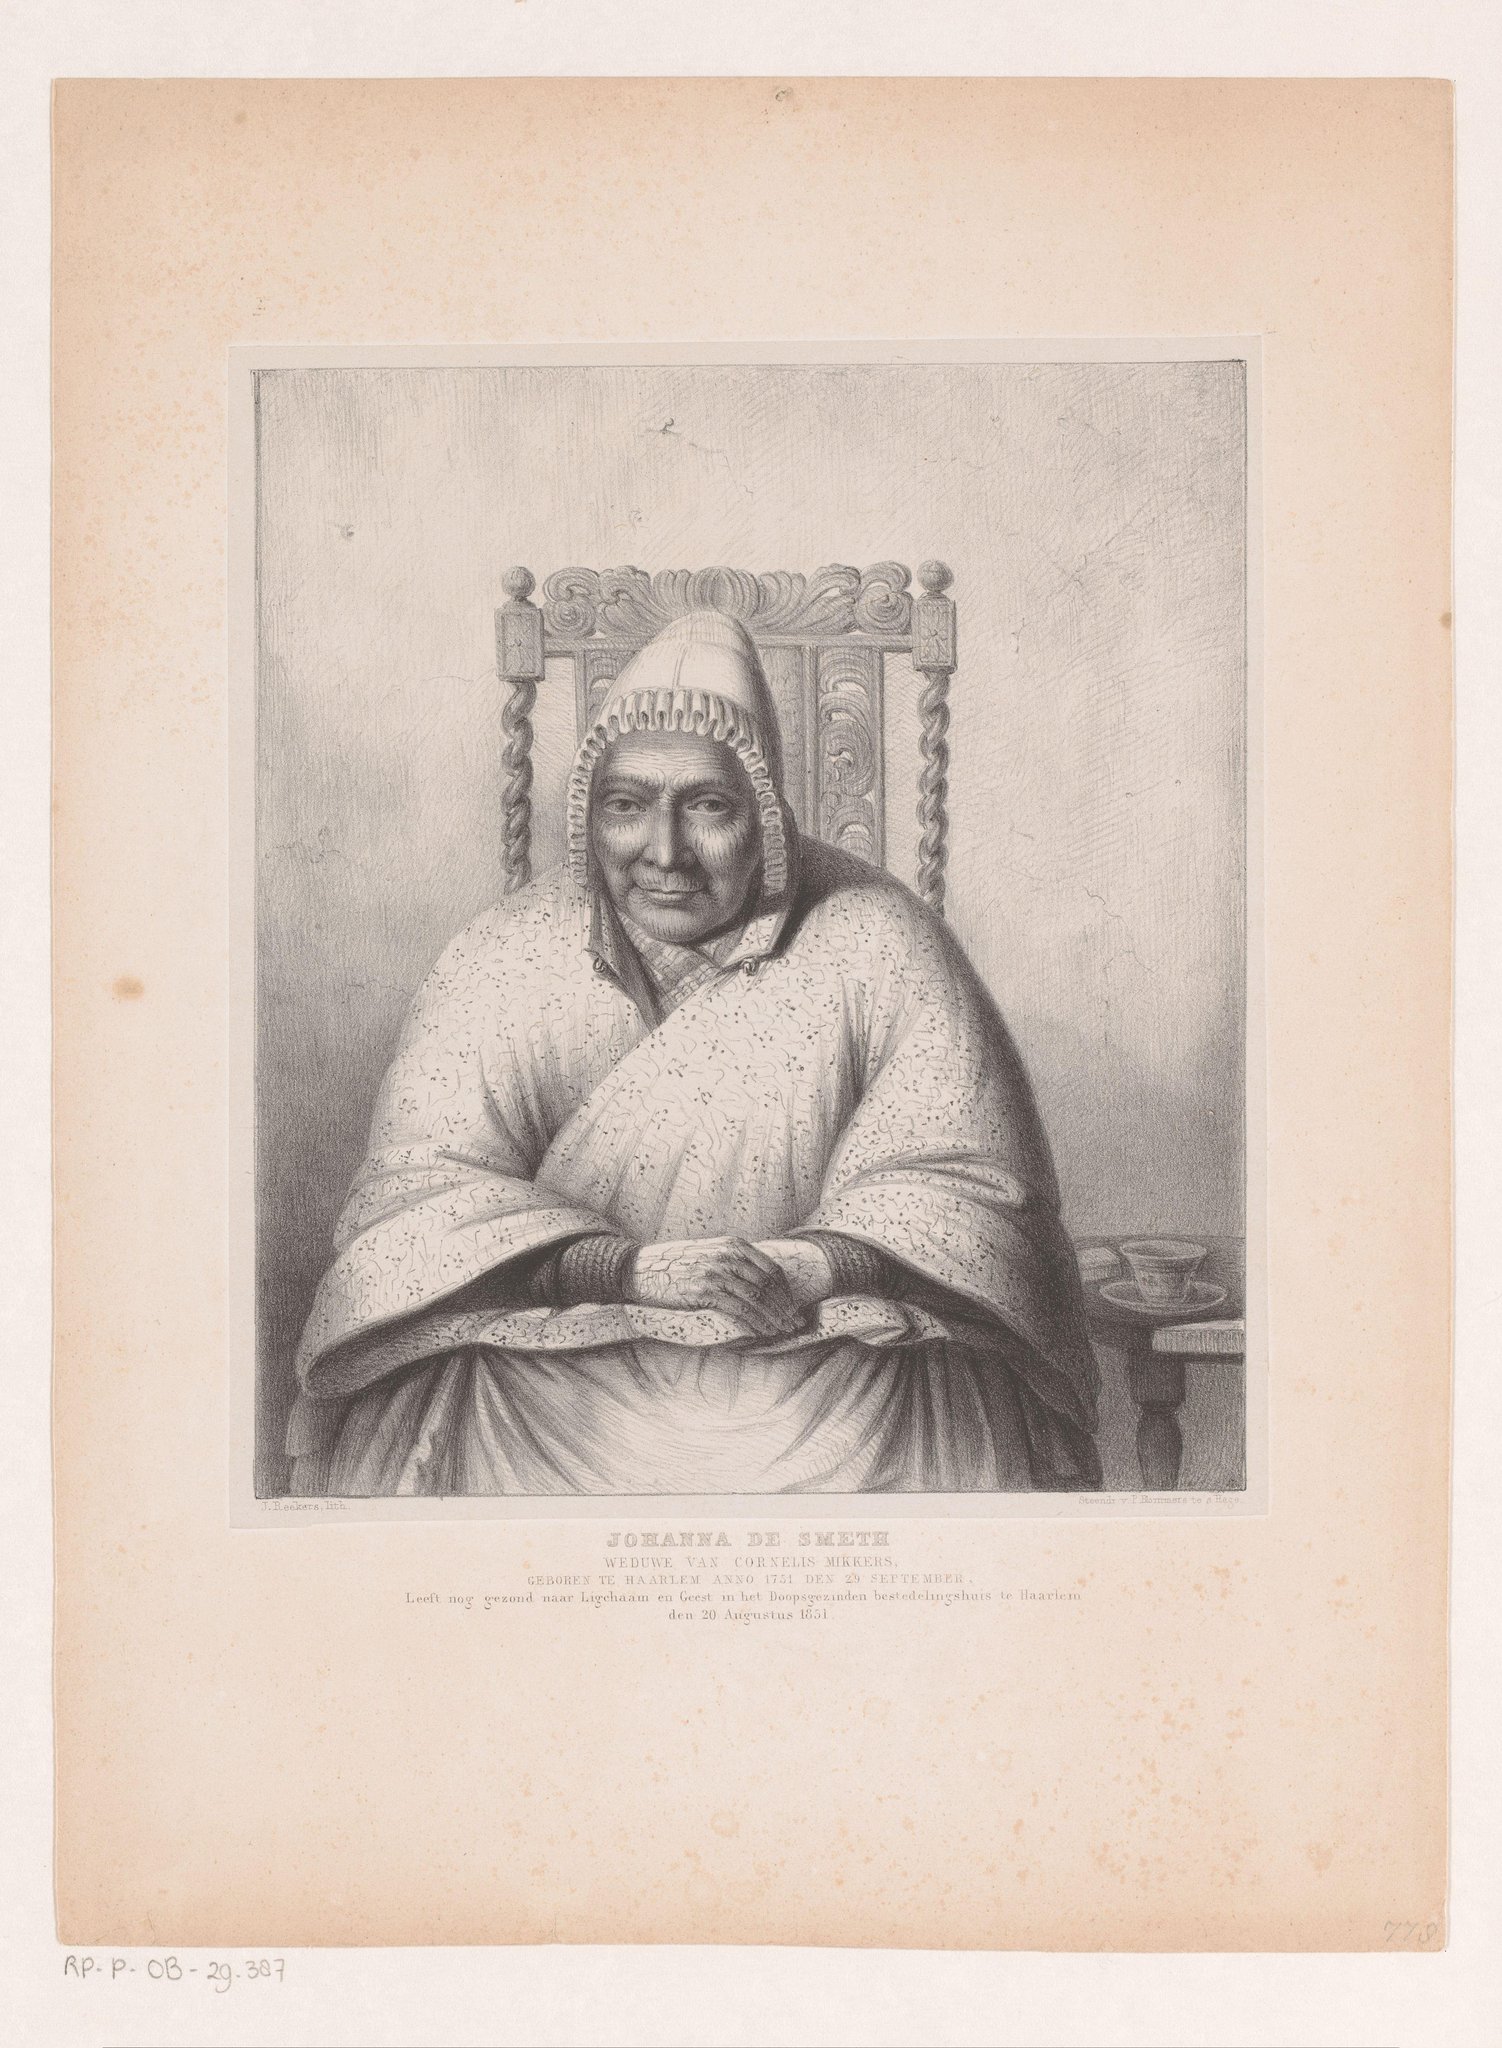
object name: print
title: Johanna de Smeth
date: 1851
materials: paper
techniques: lithograph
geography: the hague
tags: historical persons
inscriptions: collector's mark: Lugt 2228